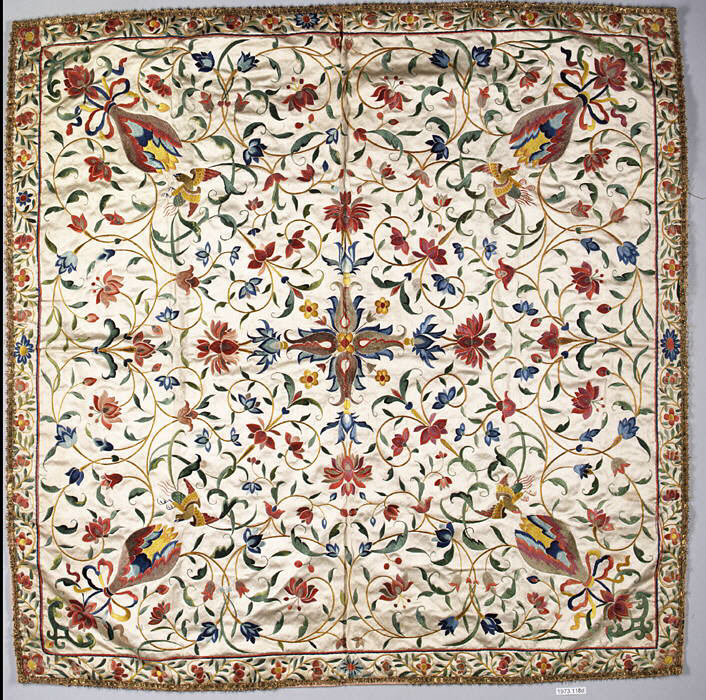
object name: chalice cover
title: Chalice veil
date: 1767-1800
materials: silk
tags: birds,flowers